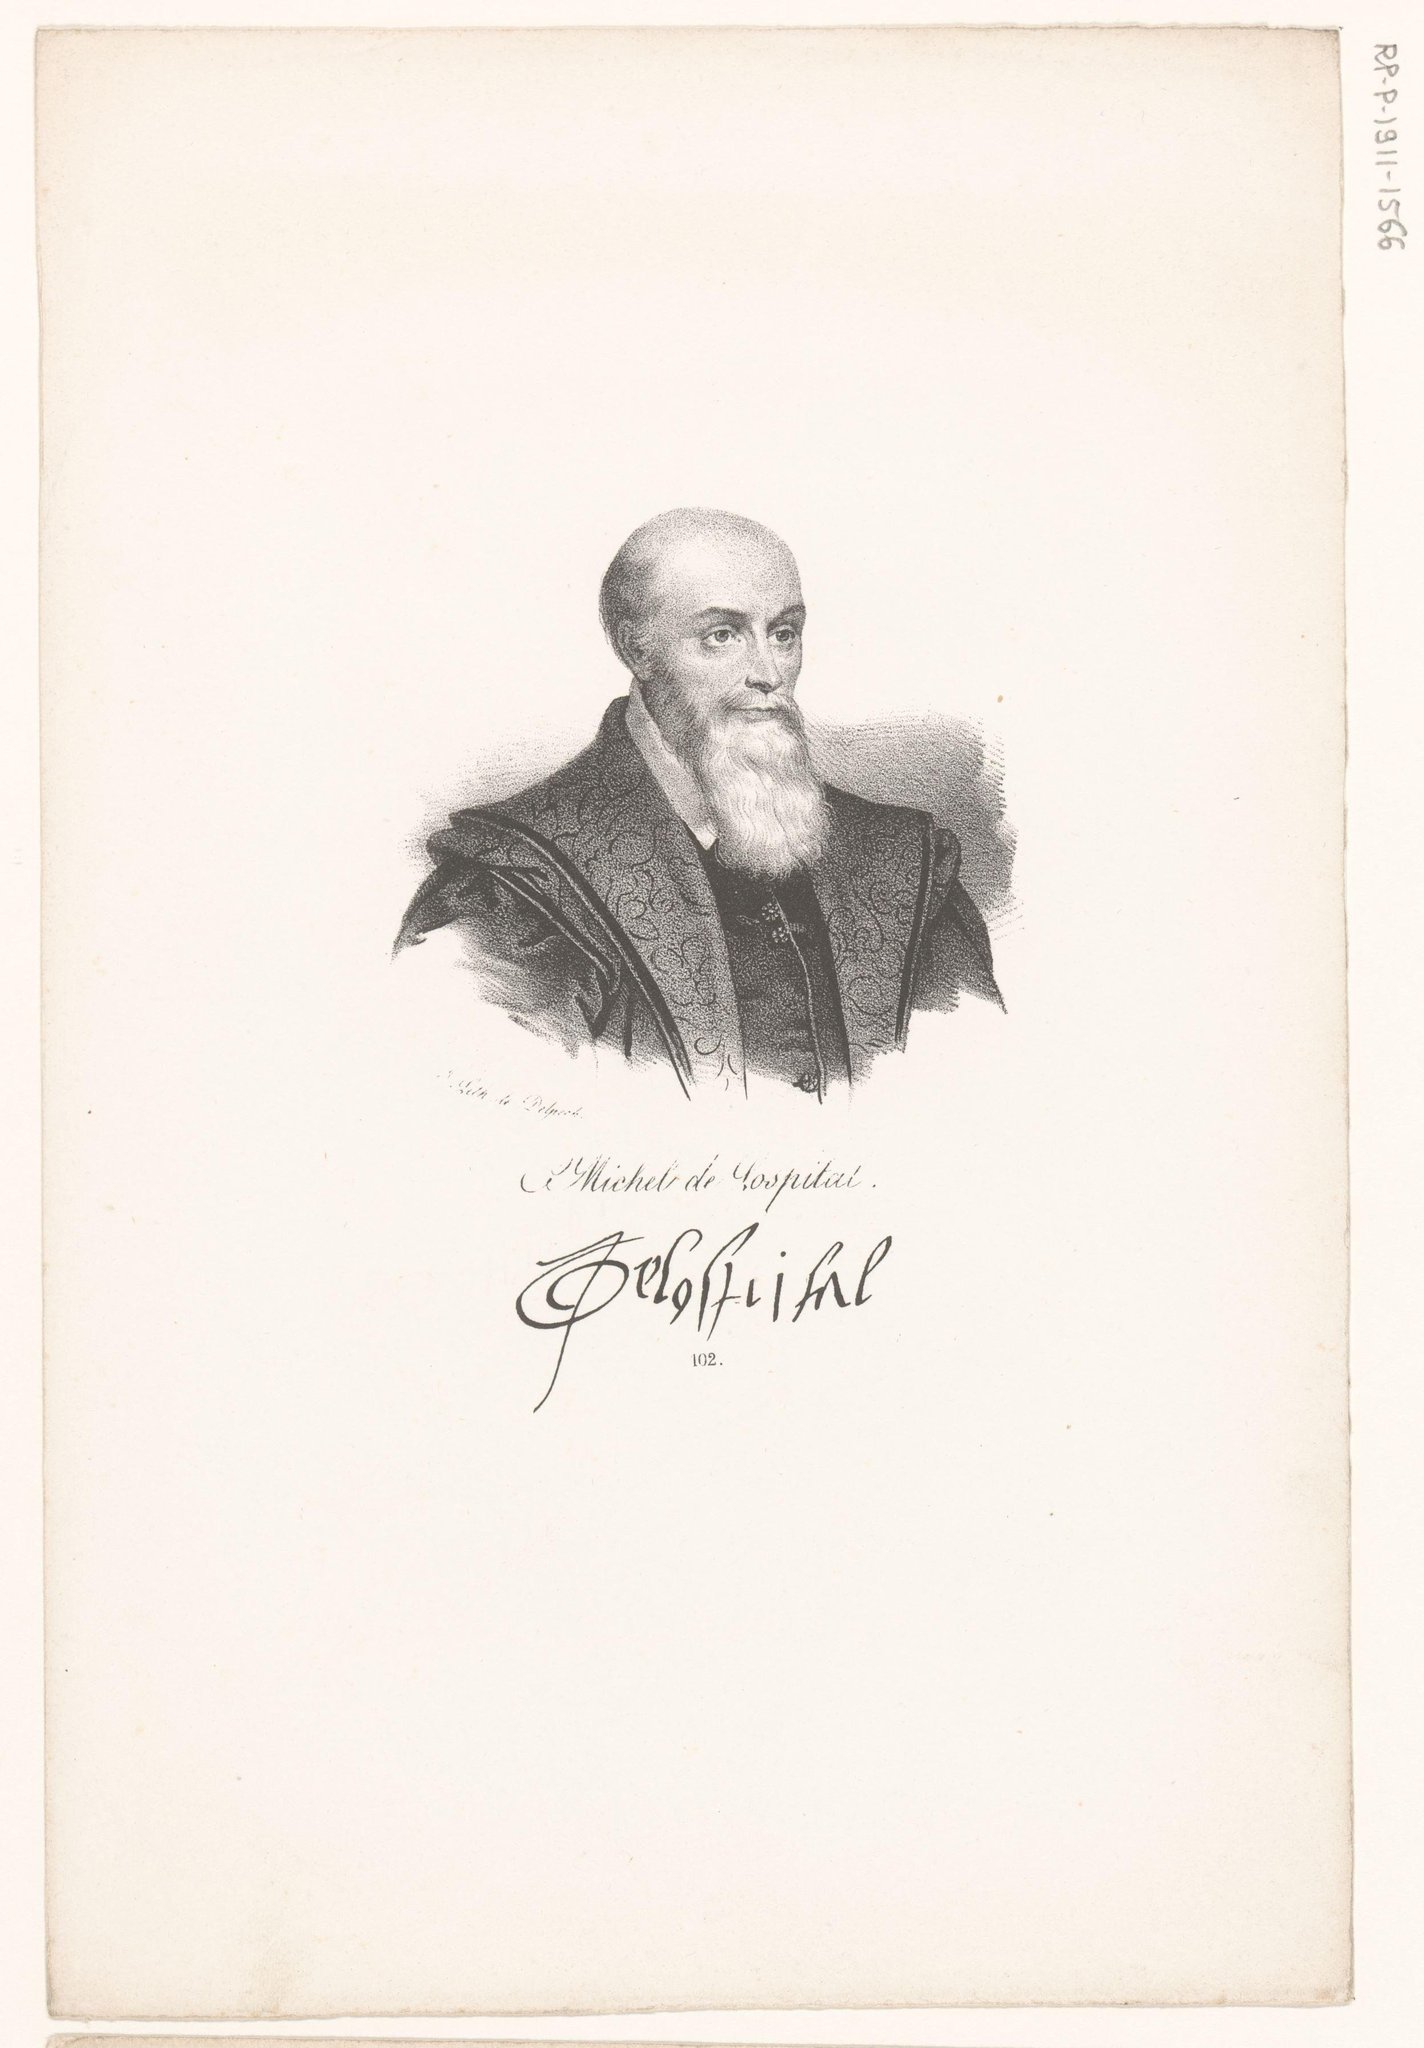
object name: print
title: Portret van Michel de l'Hospital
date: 1818-1842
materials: paper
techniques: lithograph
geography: paris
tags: historical persons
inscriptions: collector's mark: Lugt 2228a